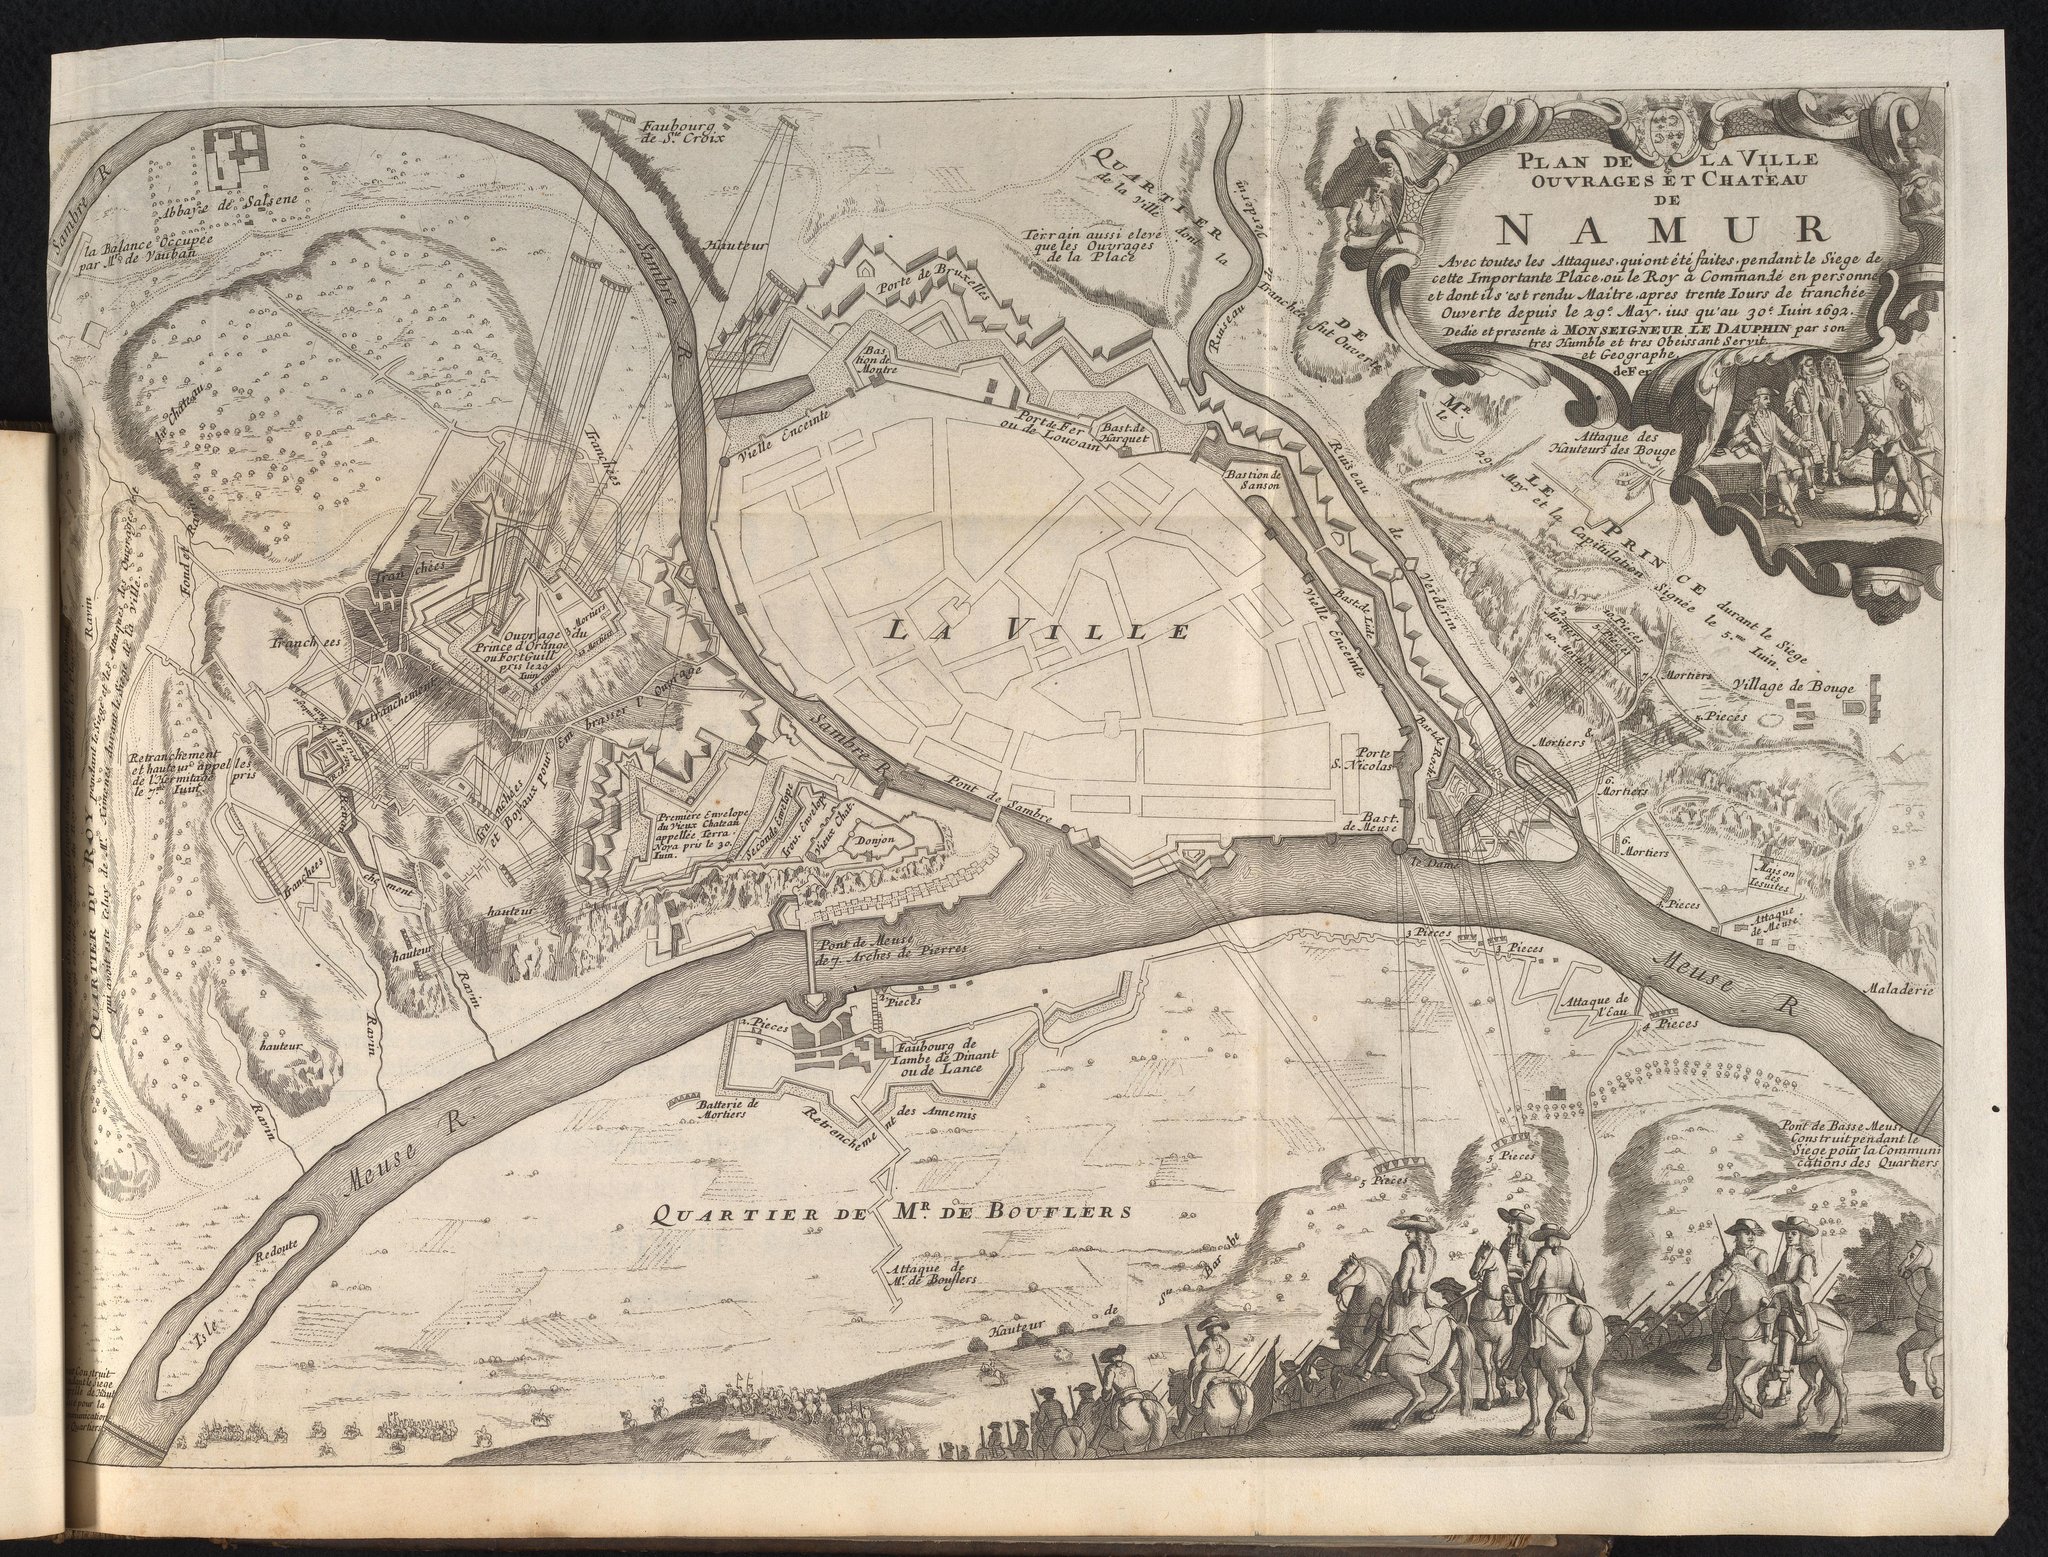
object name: print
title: Plan de la Ville ouvrages et Chateau de Namur Avec toutes les Attaques, qui ont été faites, pendant le Siege (...) depuis le 29e May jus qu au 30e Juin 1692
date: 1692-1695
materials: paper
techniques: engraving, etching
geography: france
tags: siege, position war, maps of cities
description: Kaart van de stad Namen met het kasteel, belegerd door het Franse leger, 25 mei - 30 juni 1692. Bovenaan onder de cartouche het aanbieden van de overgave van de stad aan de Franse bevelhebber. Onderaan oprukkende ruiterij. Onderdeel van het derde deel (1695) van het prentwerk waarin gebundeld zijn de acht delen van Les forces de l'Europe uitgegeven tussen 1693-1697. Het prentwerk bestaat uit 175 platen met plannen (afkomstig van Sébastien Le Prestre, Seigneur de Vauban) van vermaarde sterke steden en vestingen in de Negenjarige Oorlog. Titel en opschriften in het Frans.